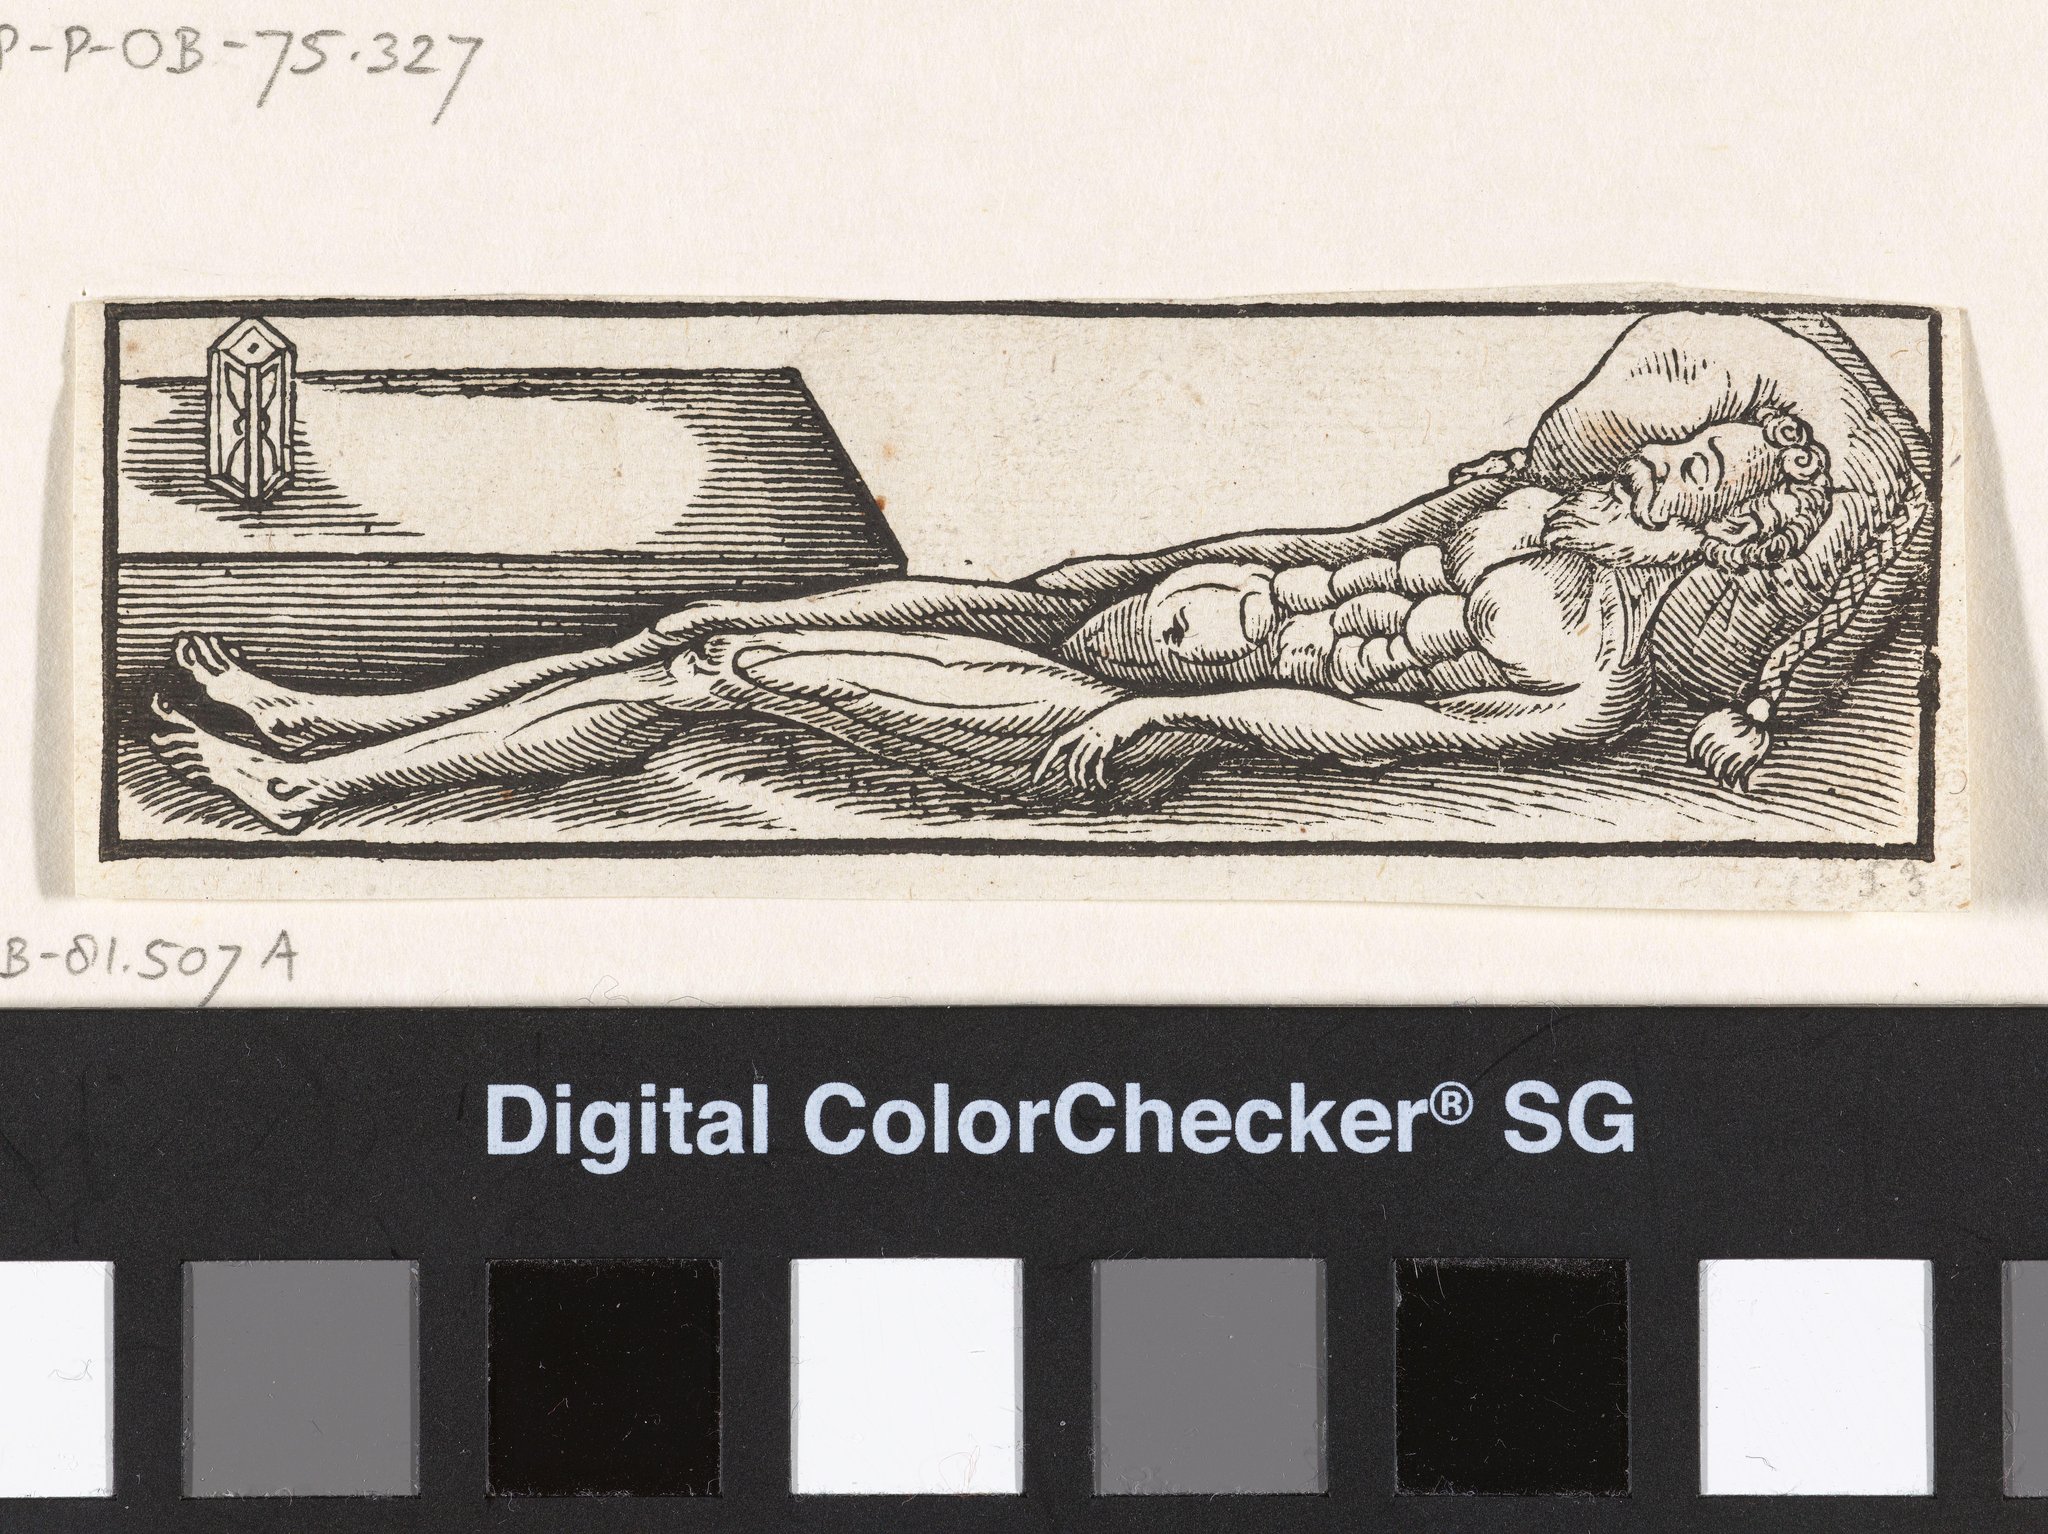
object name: print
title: Het naakte lichaam van de overleden kardinaal-infant Ferdinand van Oostenrijk, 1641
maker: Anonymous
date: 1641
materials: paper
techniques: woodcut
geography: northern netherlands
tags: brussels, landvoogd der zuidelijke nederlanden ferdinand van oostenrijk, the corpse placed on a bier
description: Het naakte lichaam van de kardinaal-infant Ferdinand van Oostenrijk, overleden op 9 november 1641. Het hoofd rust op een kussen, bij zijn voeten een zandloper. De afbeelding behoort bij een tekstblad met een lied.